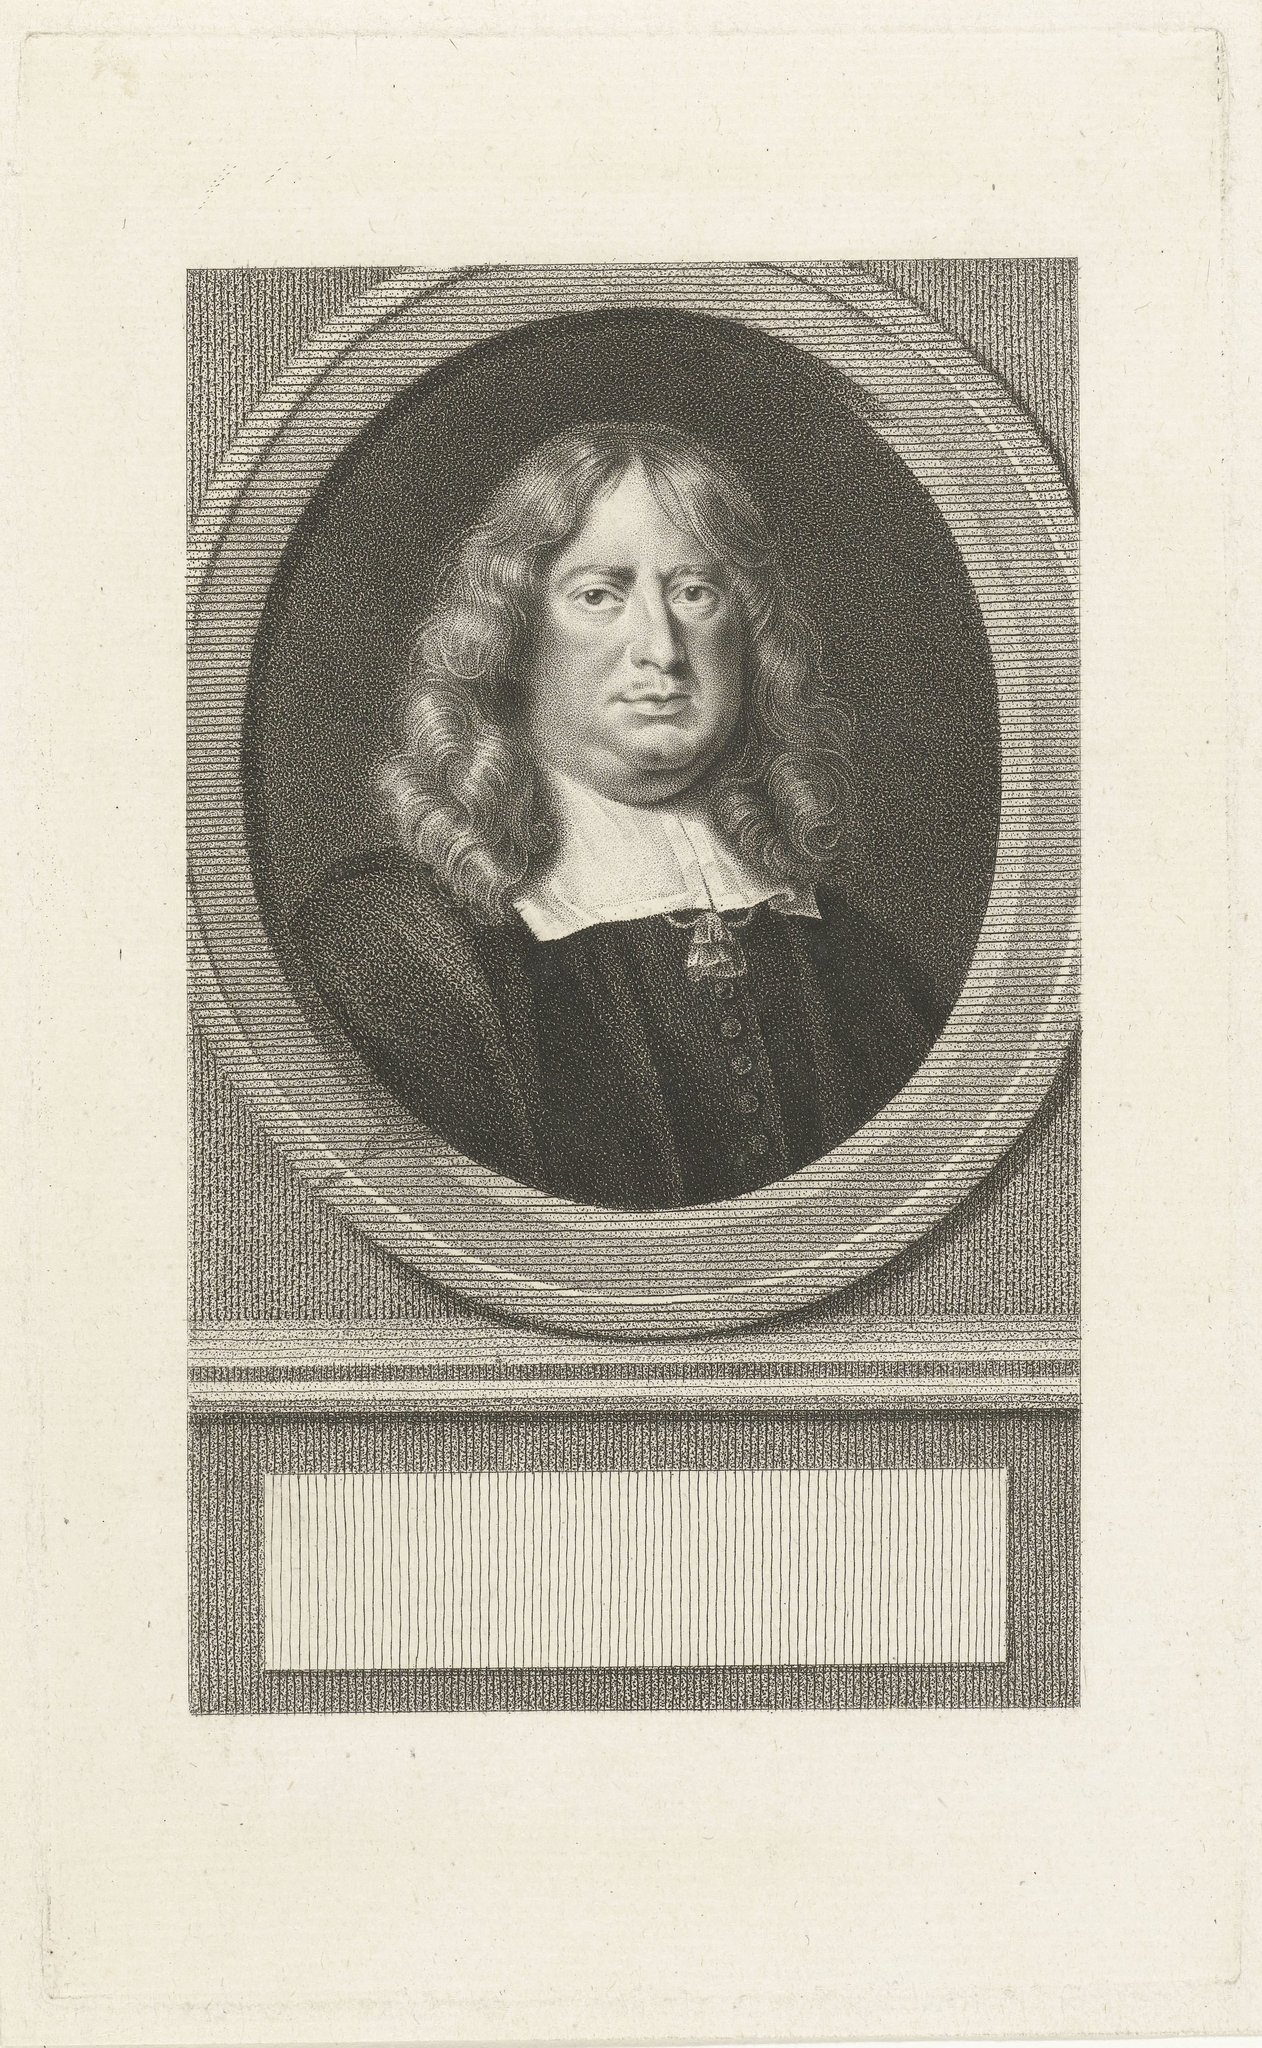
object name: print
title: Portret van Jacob van der Togt burgermeester van Gouda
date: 1792-1808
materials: paper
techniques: engraving, etching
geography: amsterdam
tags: raadsman, jacob van der tocht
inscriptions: collector's mark: Lugt 2228